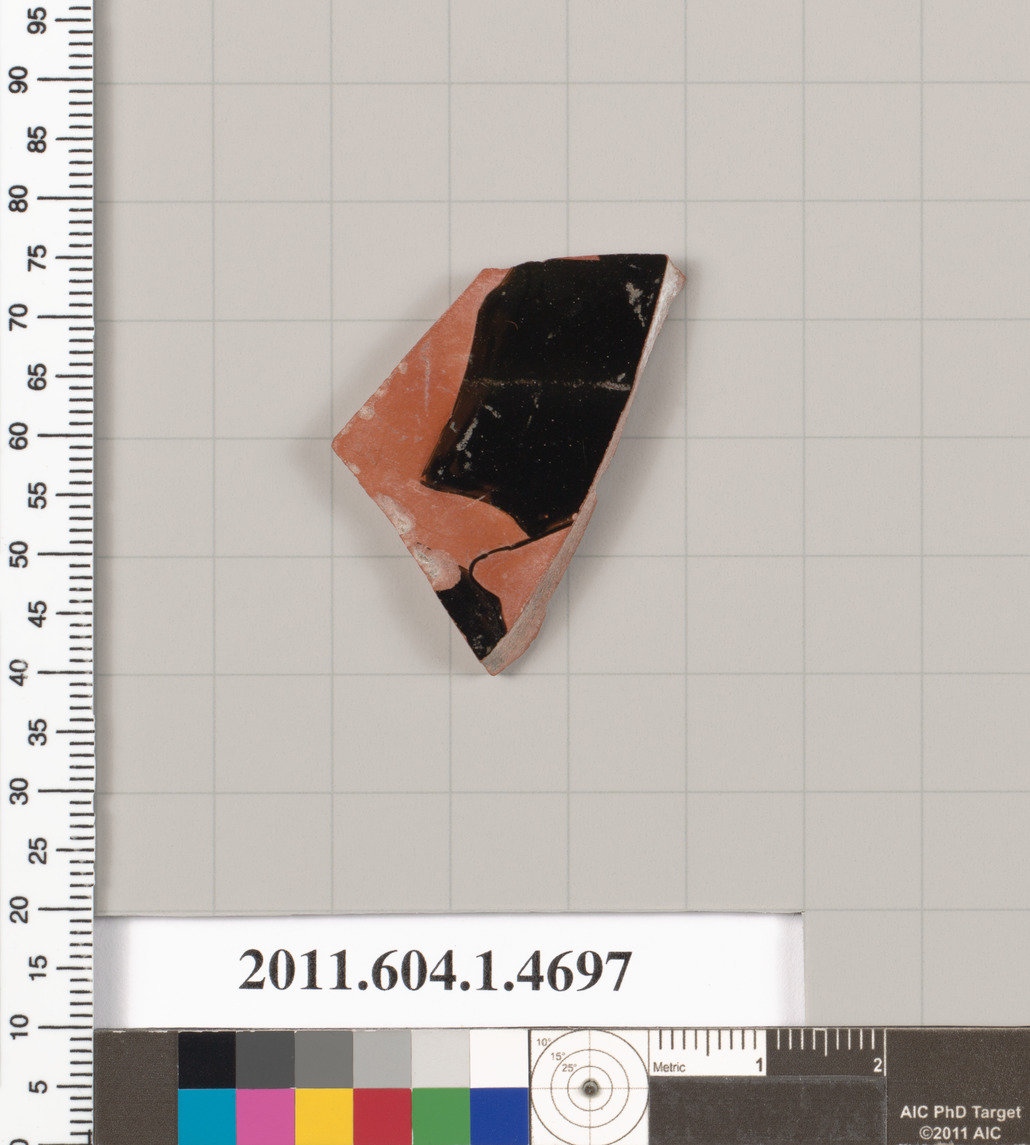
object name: kylix fragment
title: Terracotta fragment of a kylix (drinking cup)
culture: greek, attic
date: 500-480 BCE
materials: terracotta